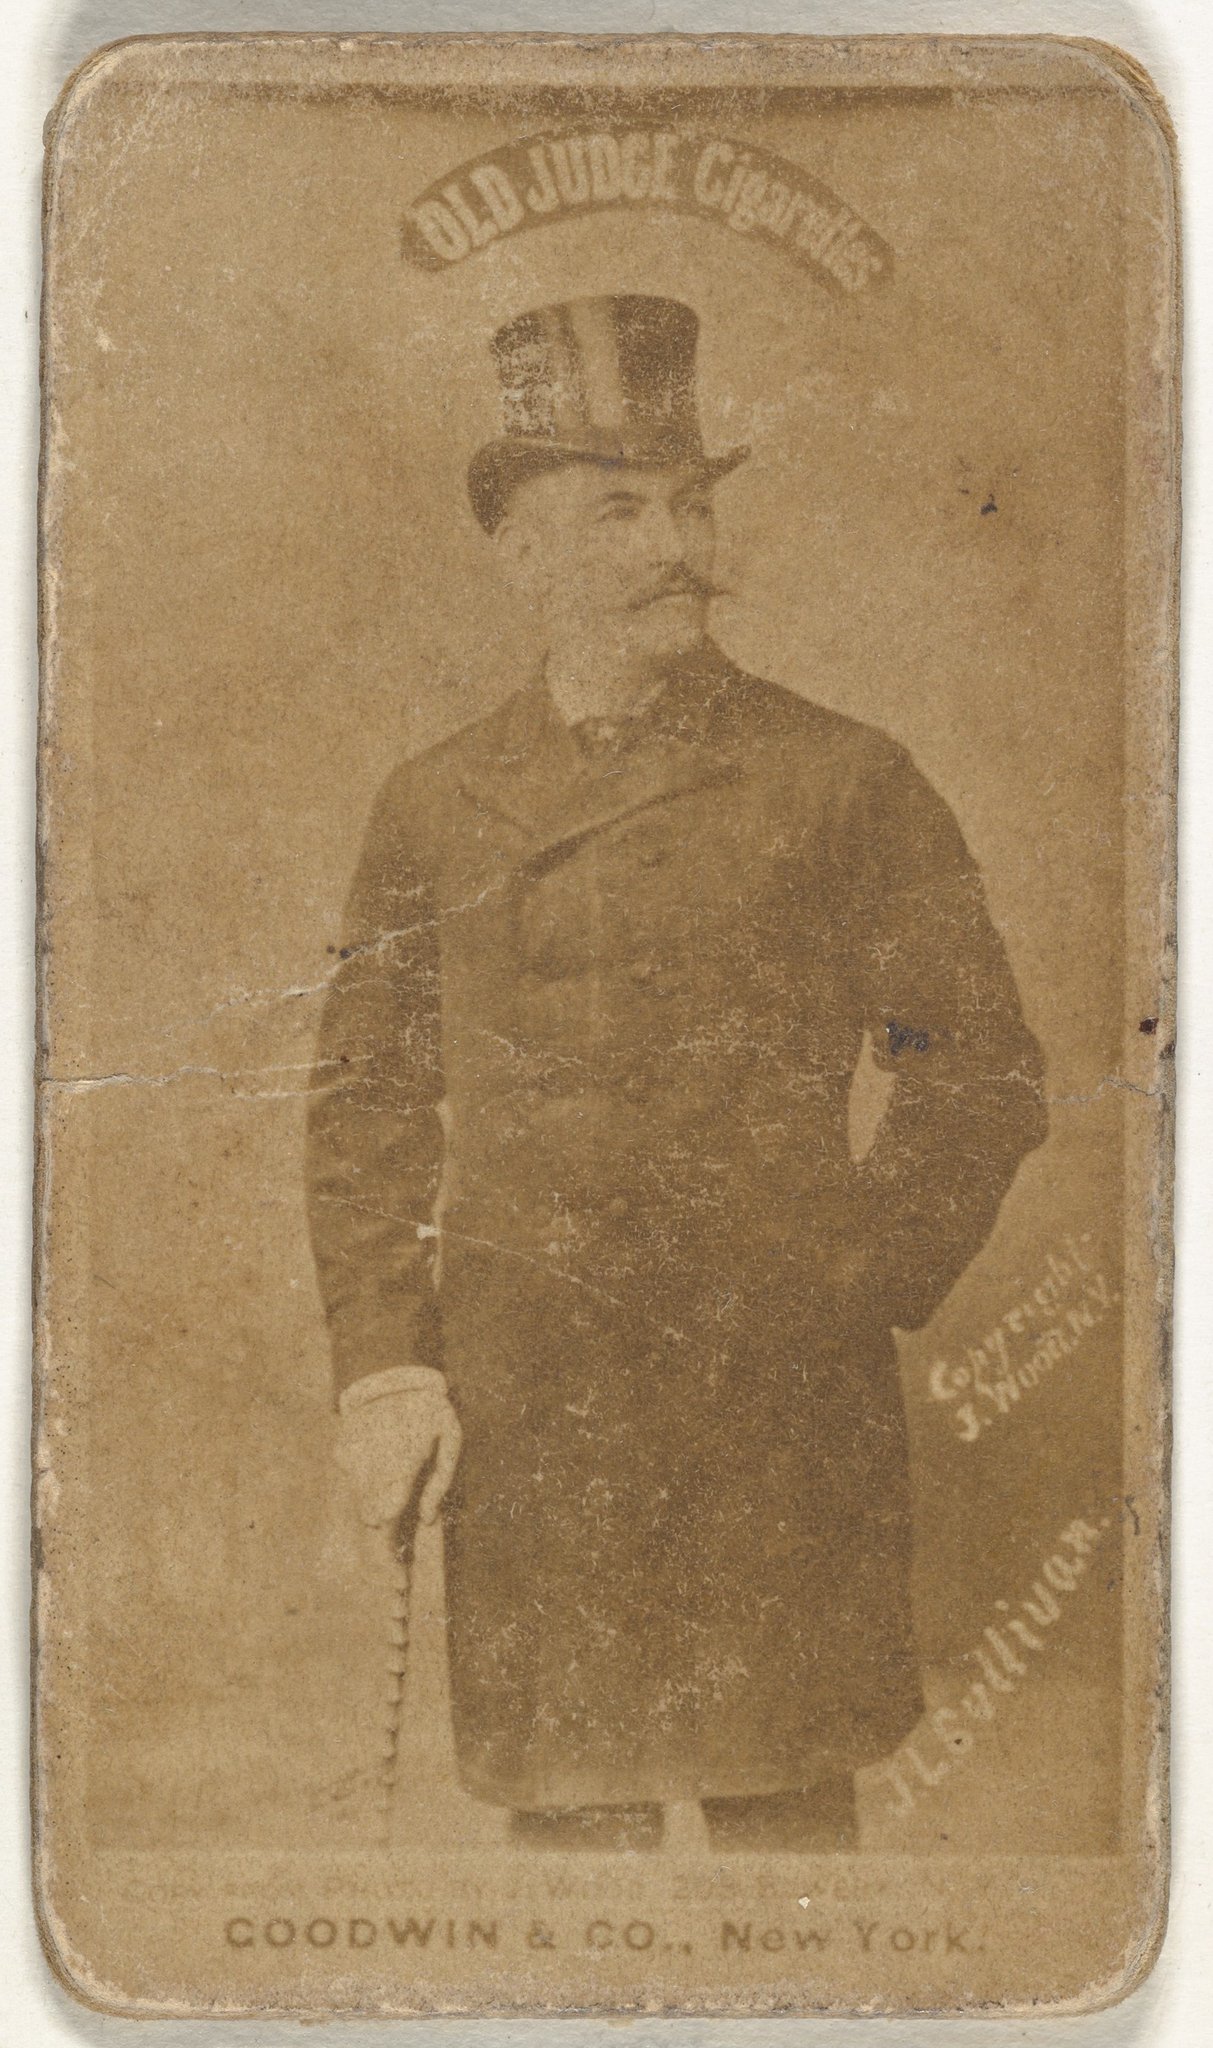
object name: photograph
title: John L. Sullivan, from the Celebrities and Prizefighters series (N174) for Old Judge Cigarettes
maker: goodwin & company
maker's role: publisher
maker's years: 1850-1950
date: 1887-1888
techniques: albumen silver print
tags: men,portraits,baseball,athletes